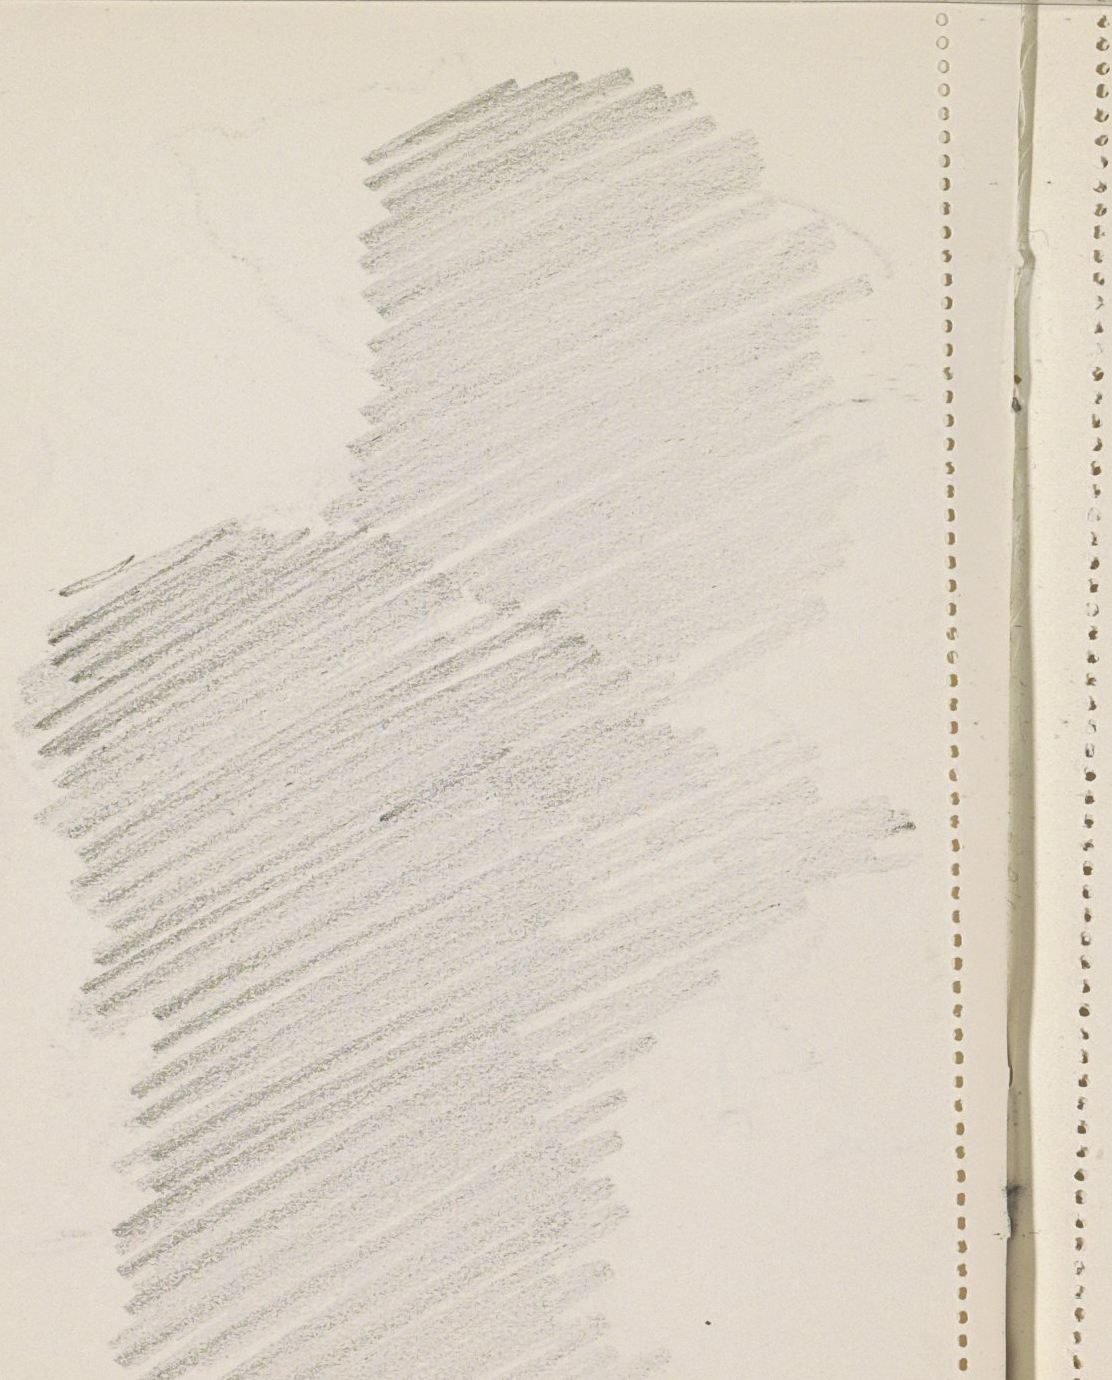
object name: sketchbook leaf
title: Studie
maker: reijer stolk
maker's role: draughtsman, print maker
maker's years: 1896-1945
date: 1906-1945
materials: paper, pencil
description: Mogelijk een silhouet van een figuur. Blad 24 verso uit een schetsboek met 42 bladen.